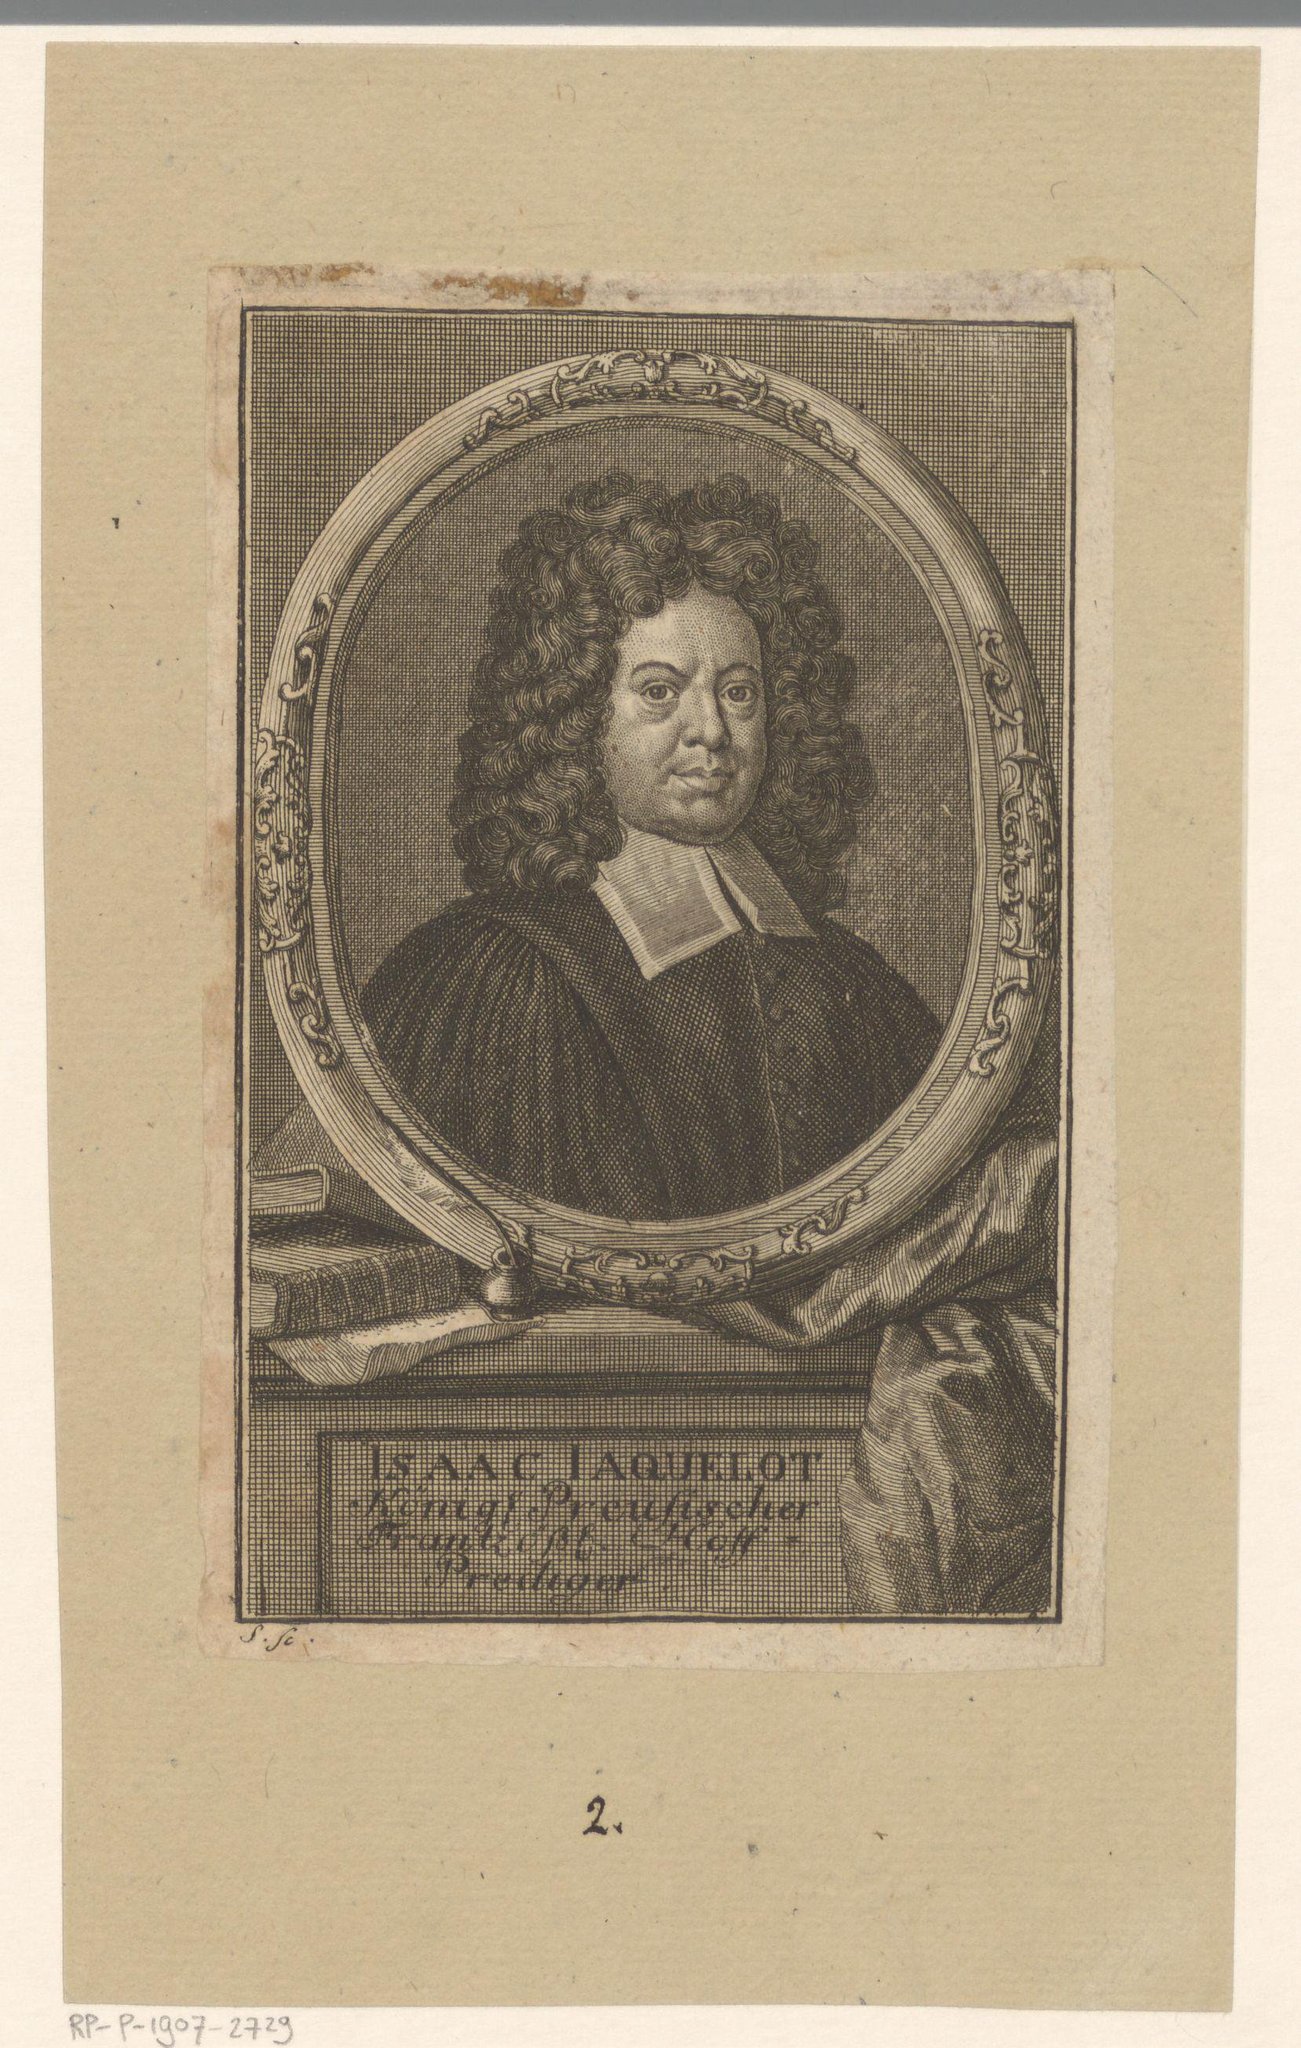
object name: print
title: Portret van Isaac Jacquelot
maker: johann christoph sysang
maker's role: print maker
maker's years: 1703-1757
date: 1745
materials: paper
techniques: engraving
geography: leipzig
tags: berlin, historical persons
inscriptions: collector's mark: Lugt 2228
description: Prent gebruikt voor de publicatie: Fortgesetzte Sammlung von Alten und Neuen Theologischen Sachen (...) Vierter Beytrag Auf das Jahr 1745. Leipzig: Carl Ludwig Jacobi, 1745. Gemonteerd op een opzetvel genummerd midden onder: 2.